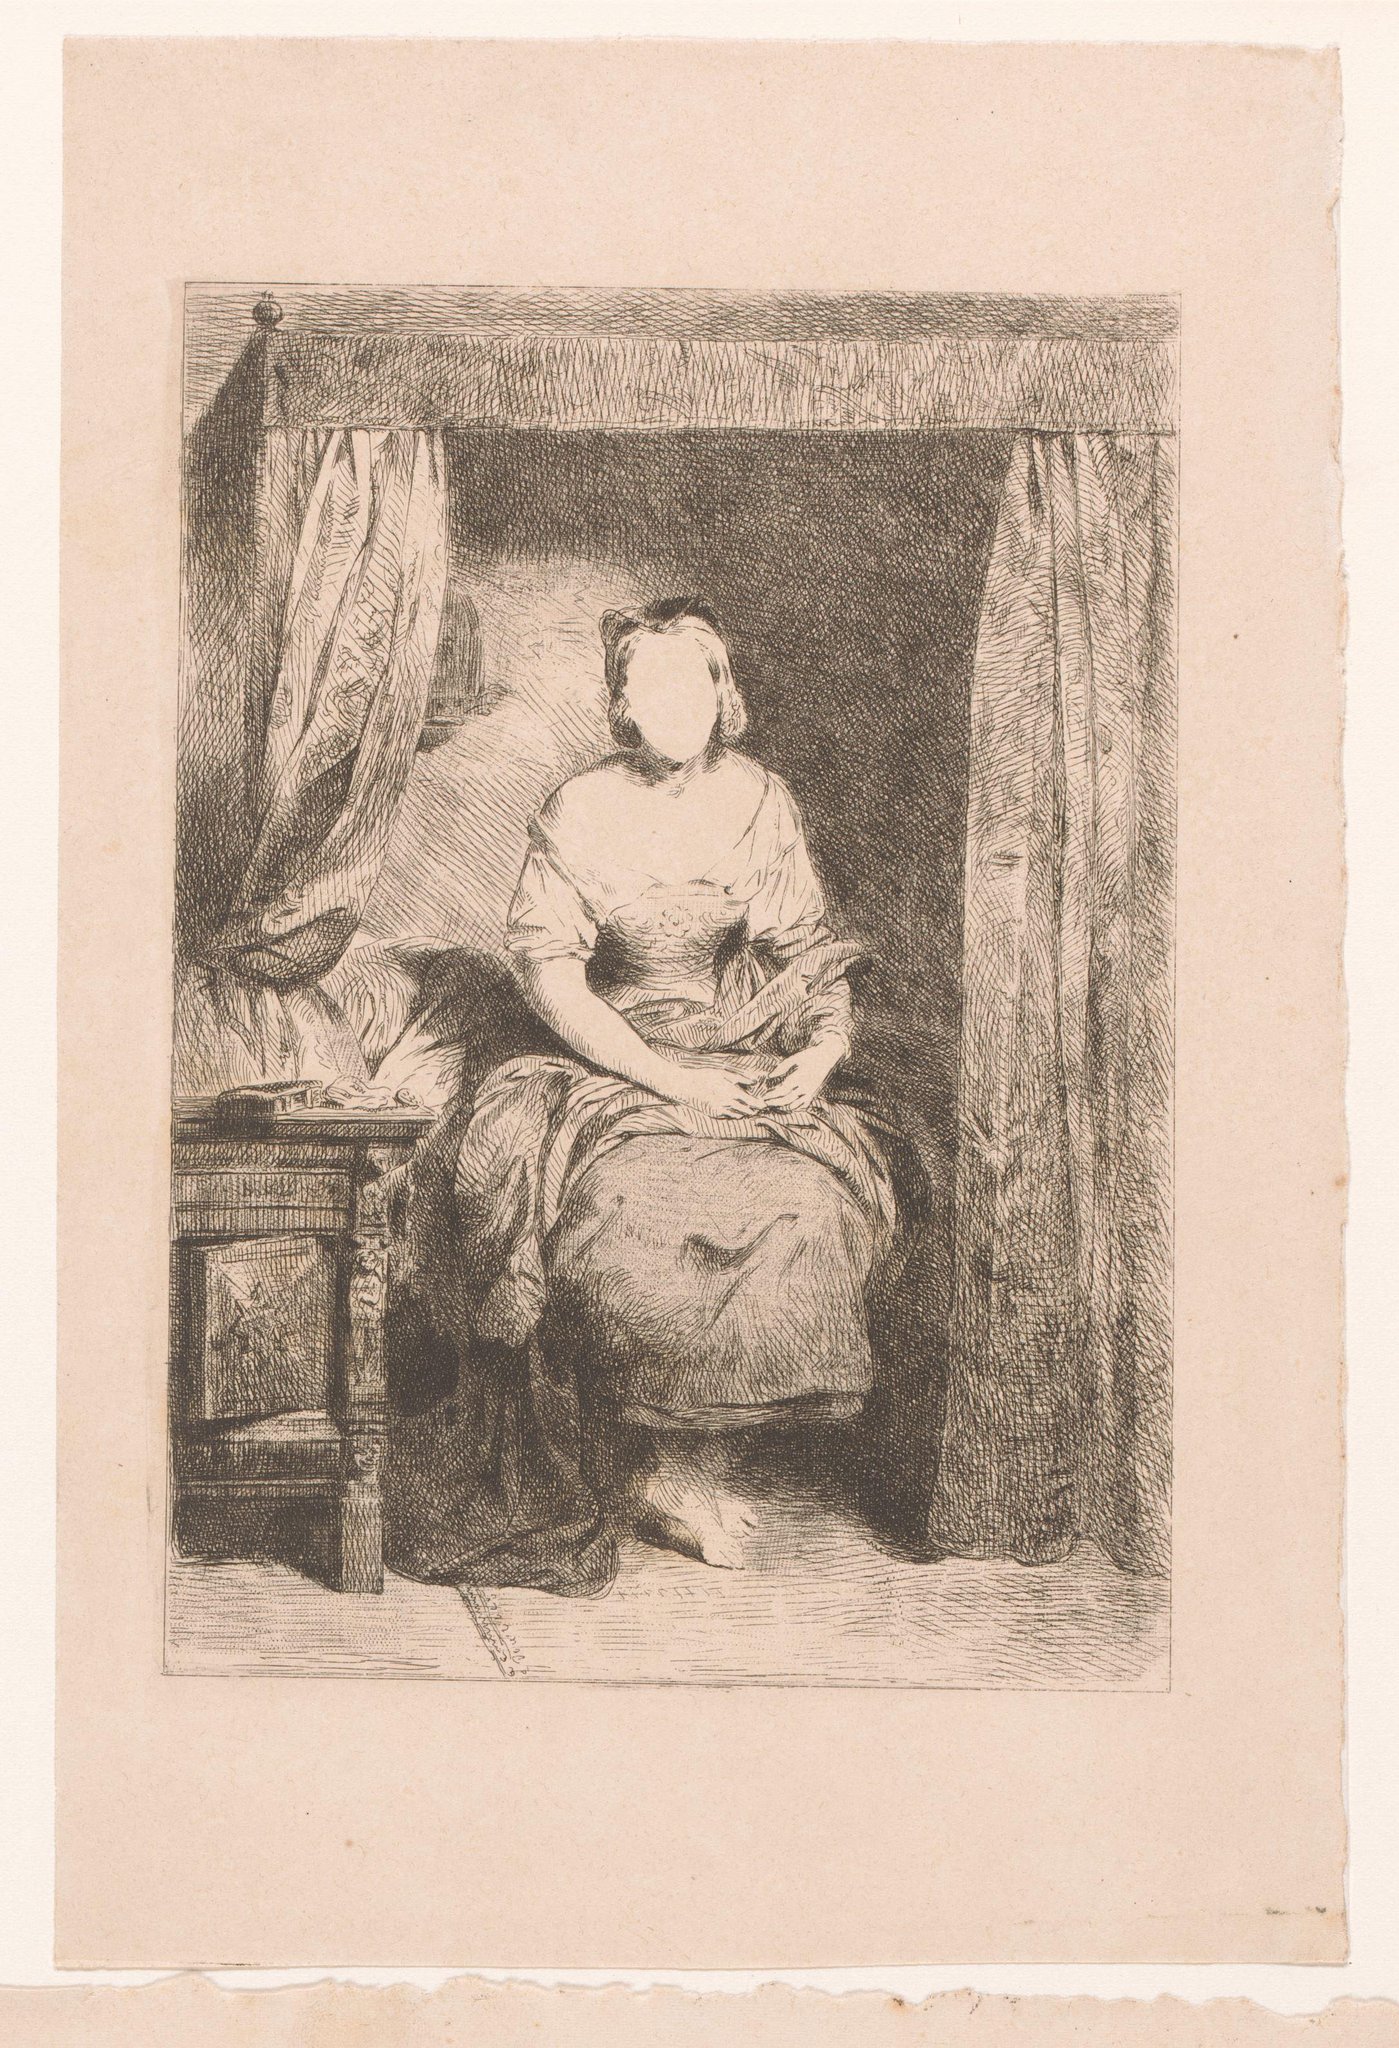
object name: print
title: Jonge vrouw gezeten op een bed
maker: gustave wappers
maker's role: draughtsman, painter, print maker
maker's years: 1803-1874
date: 1813-1874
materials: paper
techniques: etching, roulette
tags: adult woman, bed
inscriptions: collector's mark: Lugt 2228